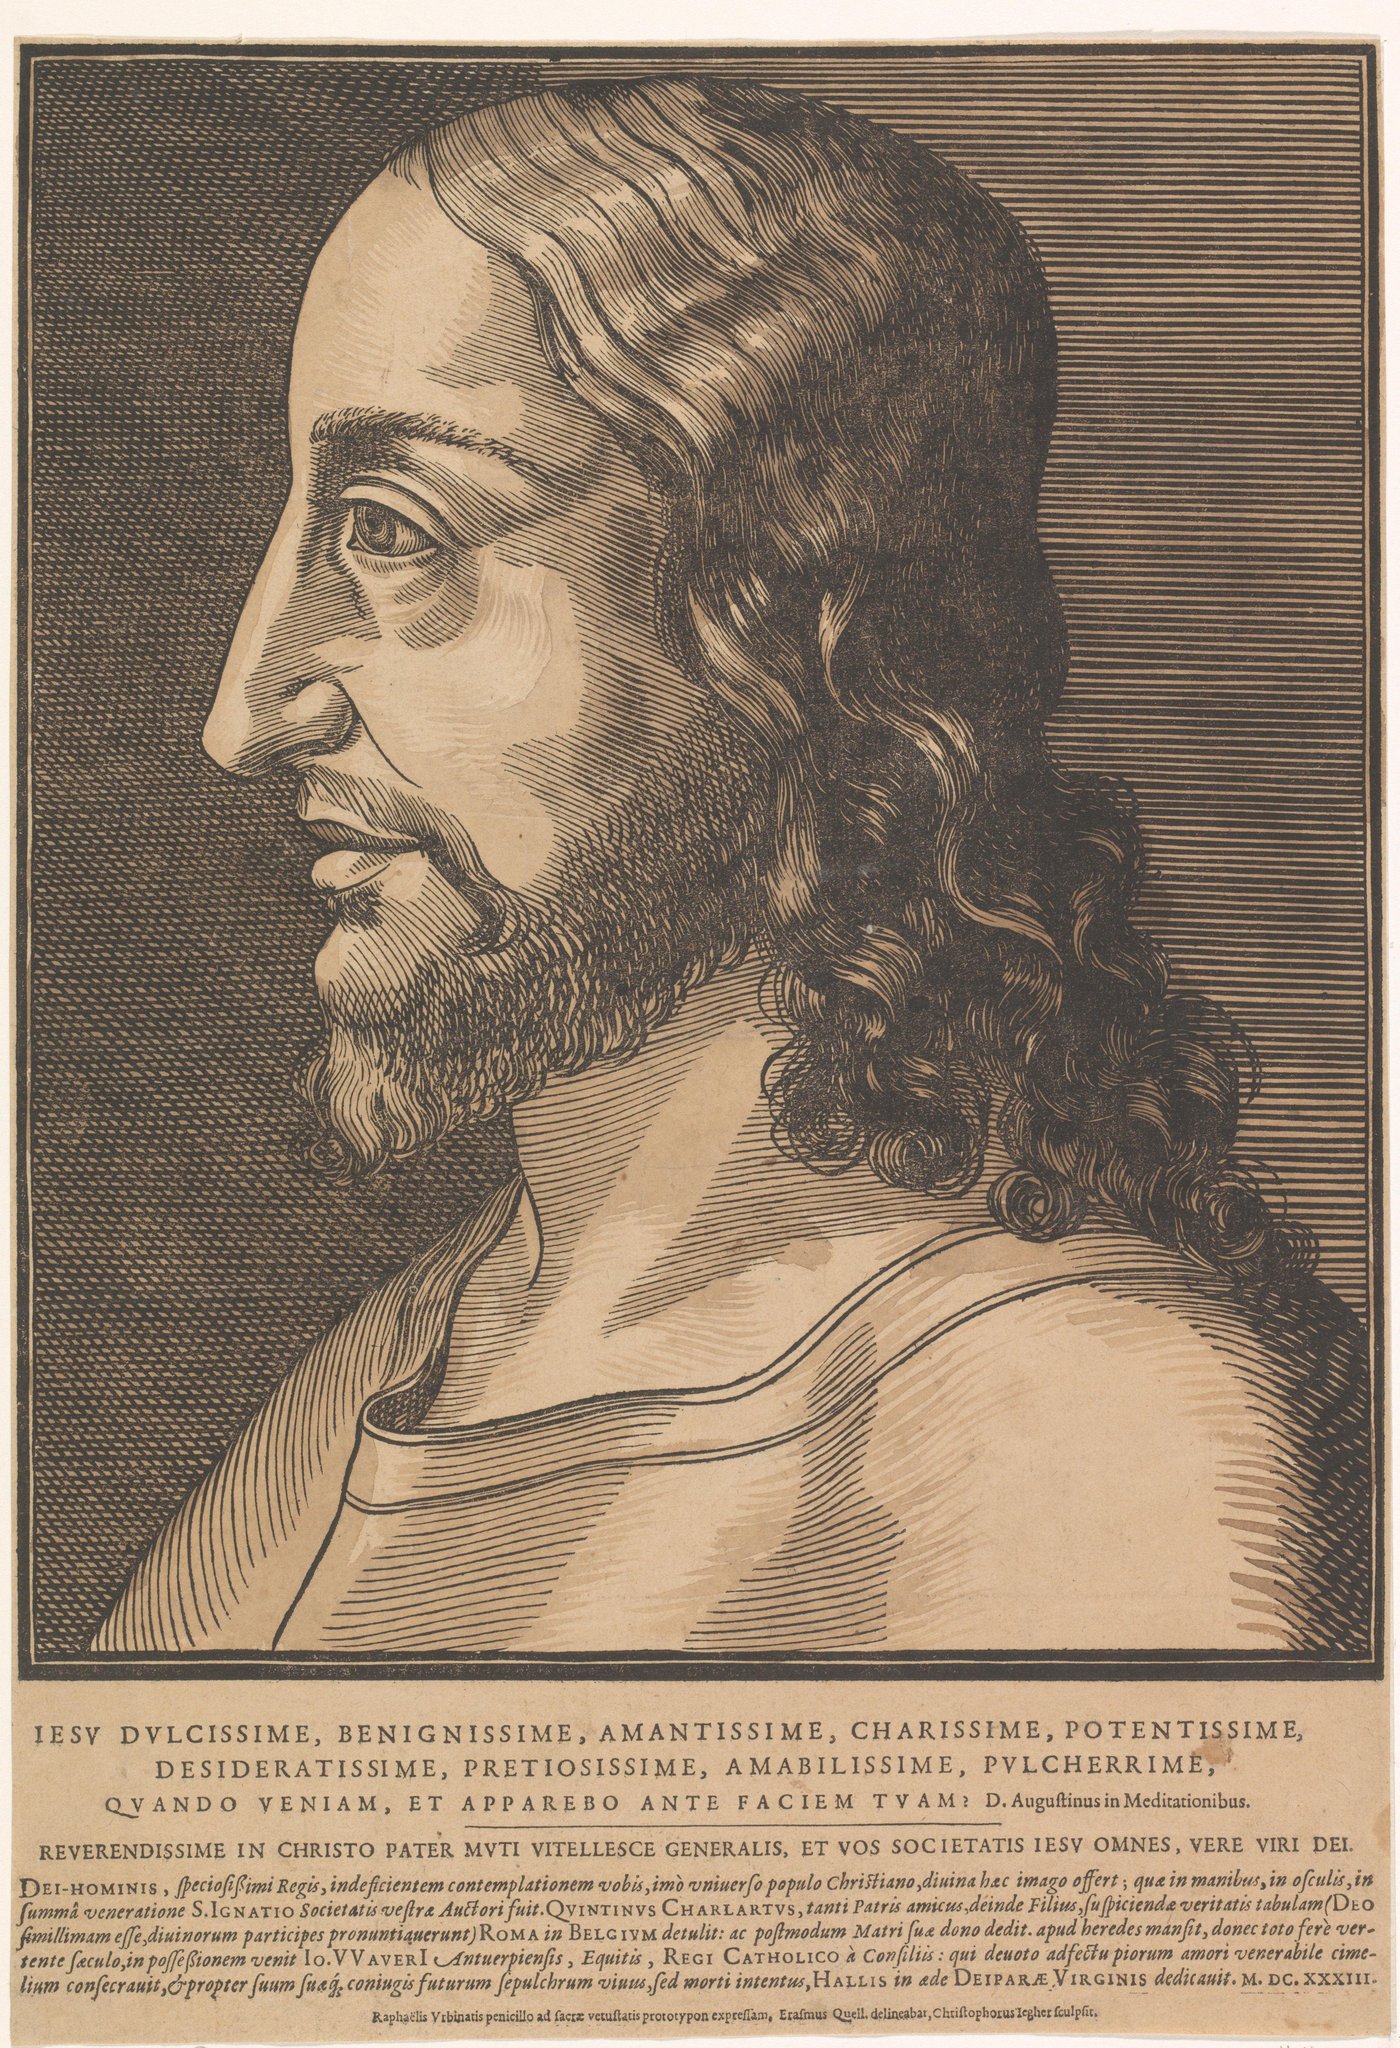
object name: print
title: Christus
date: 1633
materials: paper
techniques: woodcut, letterpress printing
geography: southern netherlands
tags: christ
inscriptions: collector's mark: Lugt 240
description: In de ondermarge negen regels Latijnse tekst.